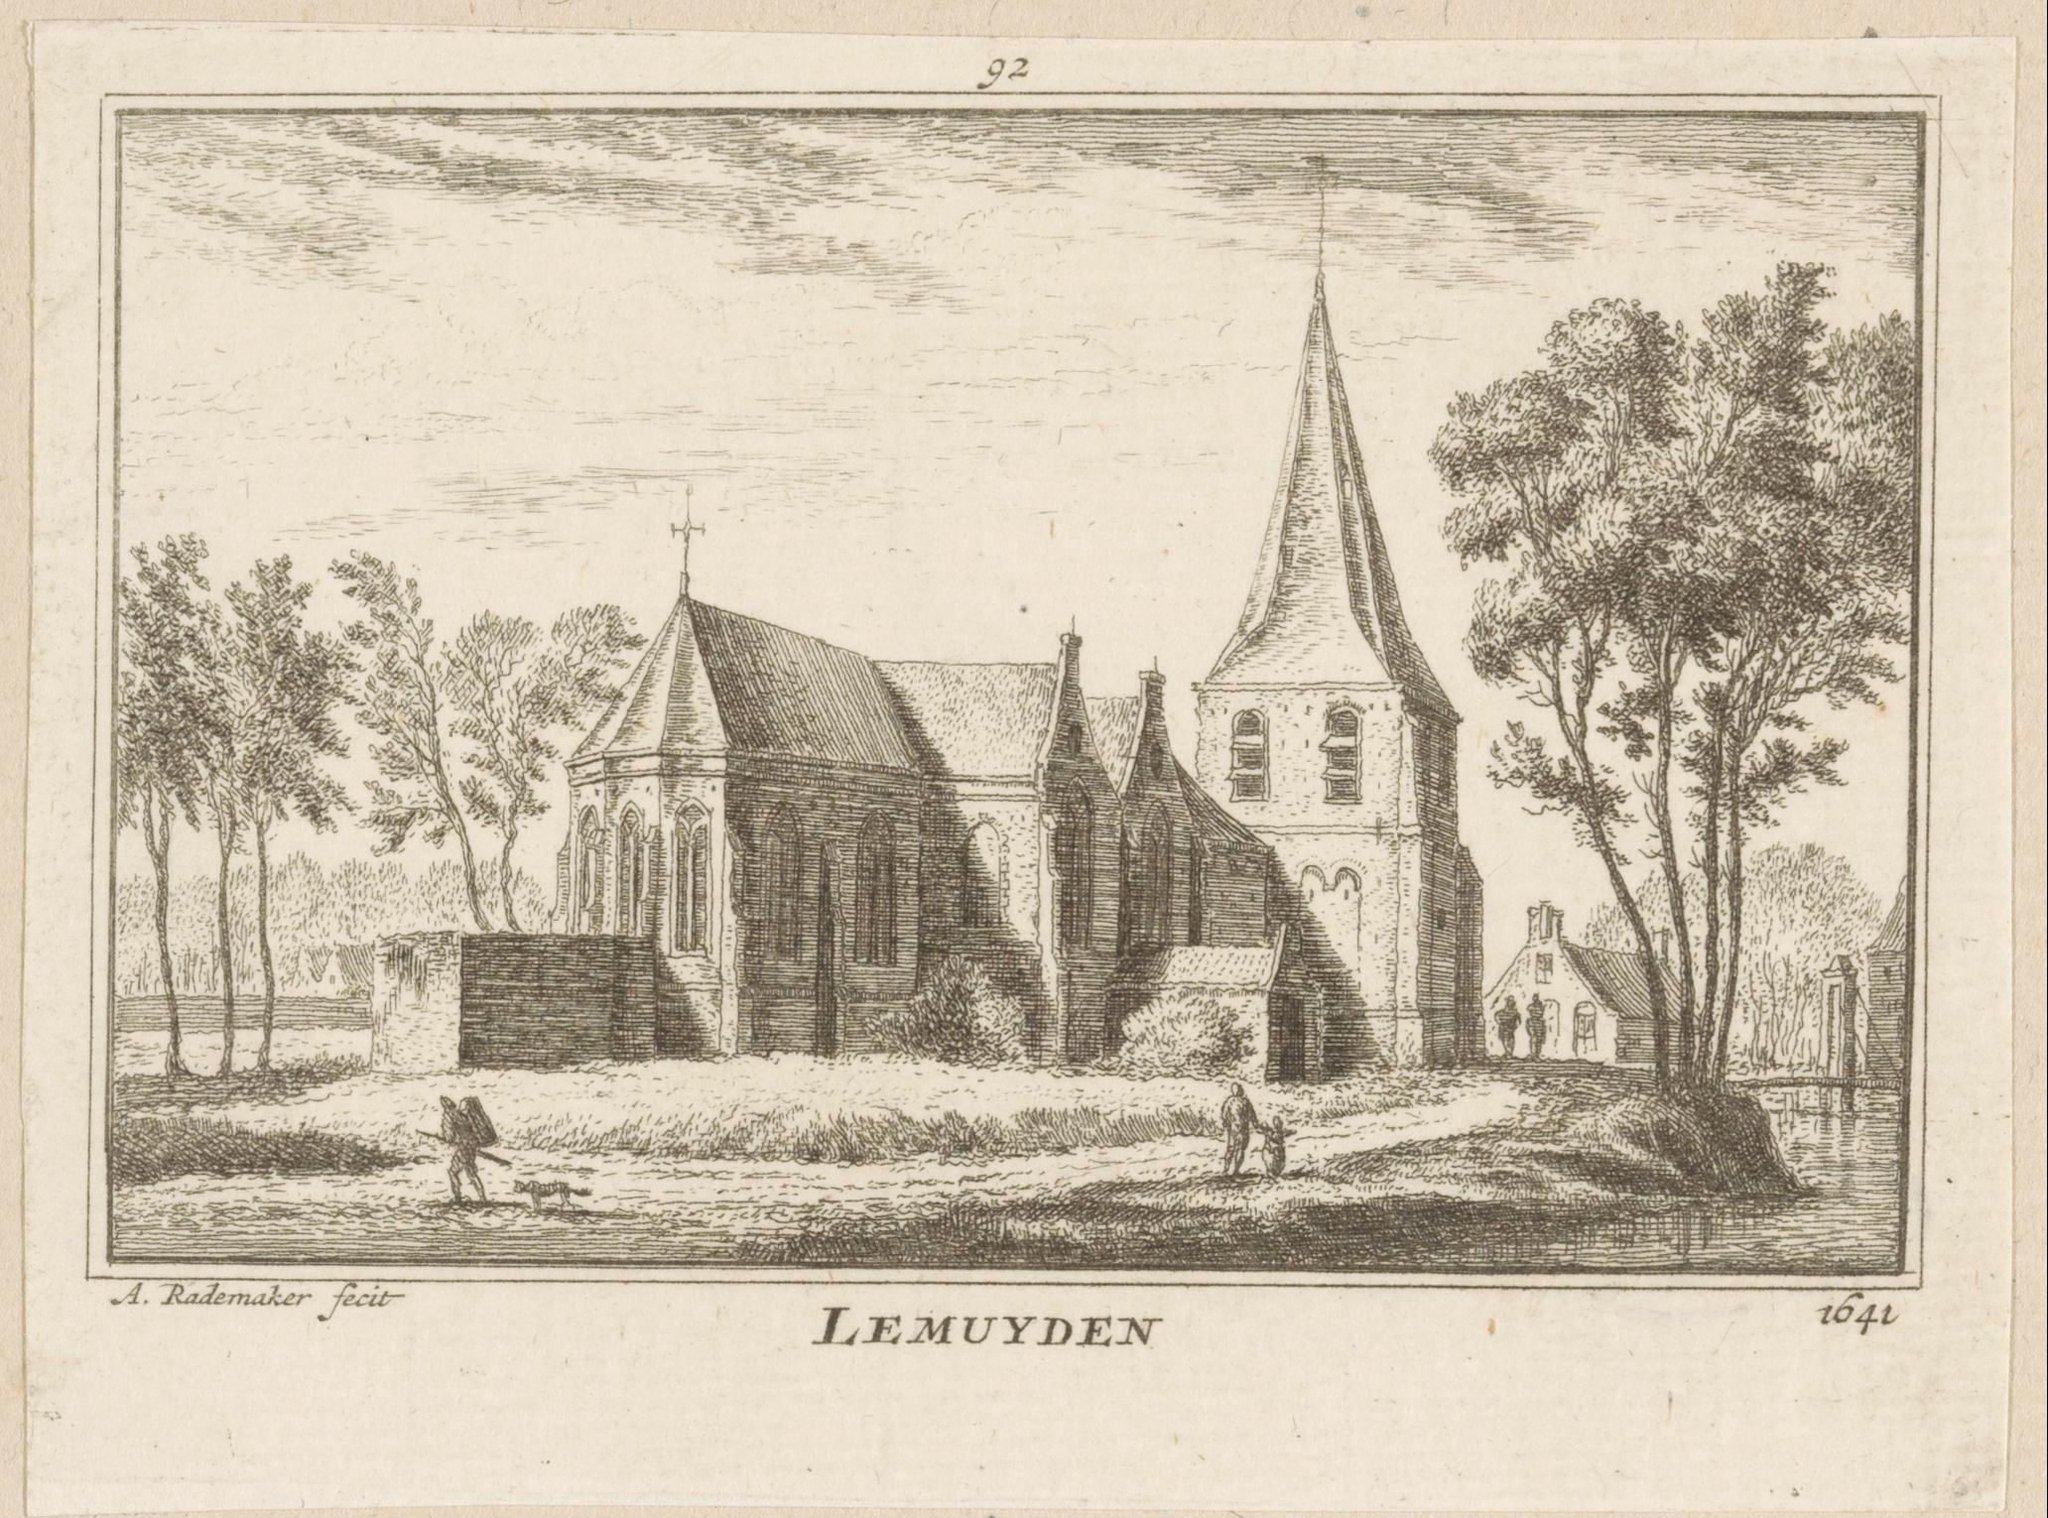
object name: book illustration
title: Gezicht op de kerk te Leimuiden, 1641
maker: abraham rademaker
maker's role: draughtsman, print maker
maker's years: 1676-1735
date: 1725-1803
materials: paper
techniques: engraving, etching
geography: amsterdam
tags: church (exterior)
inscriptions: collector's mark: Lugt 2228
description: Prent ook gebruikt in: Rademaker, Abraham. Kabinet van Nederlandsche outheden en gezichten: vervat in 300 konstplaaten (…). 2 delen. Amsterdam: Willem Barents, 1725, dl. 1, ill. 92. Na 1725 is deze prent nog in verschillende heruitgaven verschenen, uitgegeven in 1727-1733, 1770-1771 en 1792-1803. Uit welke uitgave het huidige exemplaar precies komt is niet na te gaan.